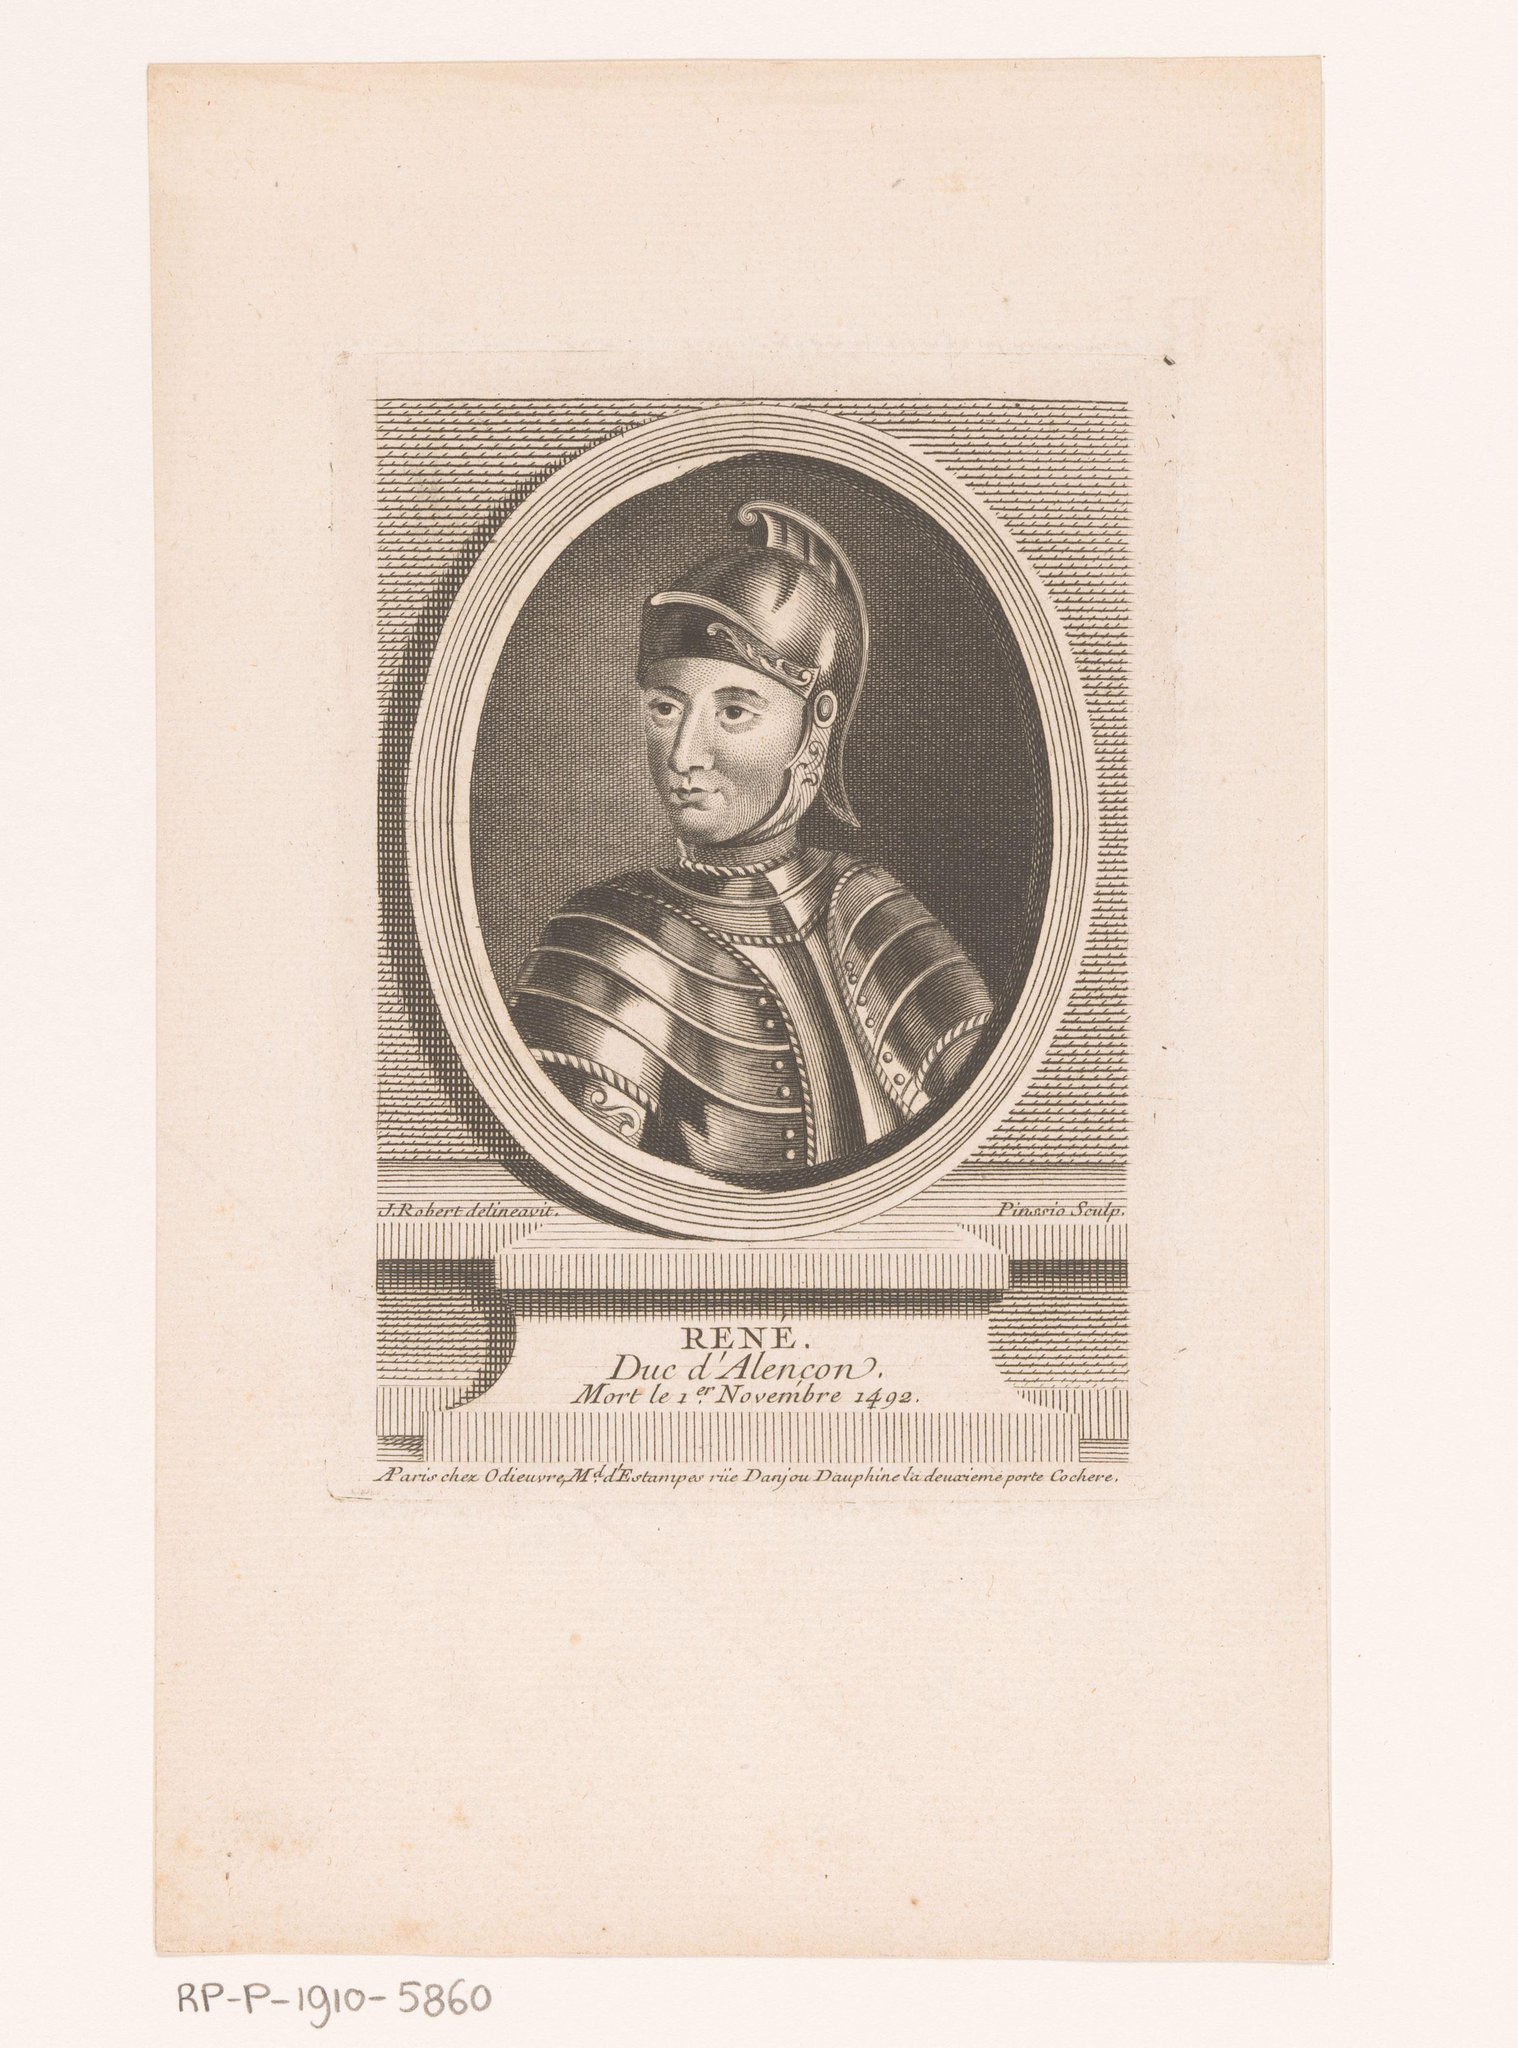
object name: book illustration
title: René.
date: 1755-1765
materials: paper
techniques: engraving, etching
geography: paris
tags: historical persons, nobility and patriciate; chivalry, knighthood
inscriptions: collector's mark: Lugt 2228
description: Prent uit: Dreux du Radier, Jean-François. L'Europe illustré, contenant l'histoire abregée des souverains, des princes, des prélats, des ministres, (...) en Europe: dans le XVe. siècle compris, jusqu'à présent. Parijs: Michel Odieuvre en André-François Le Breton, 1755-1765.